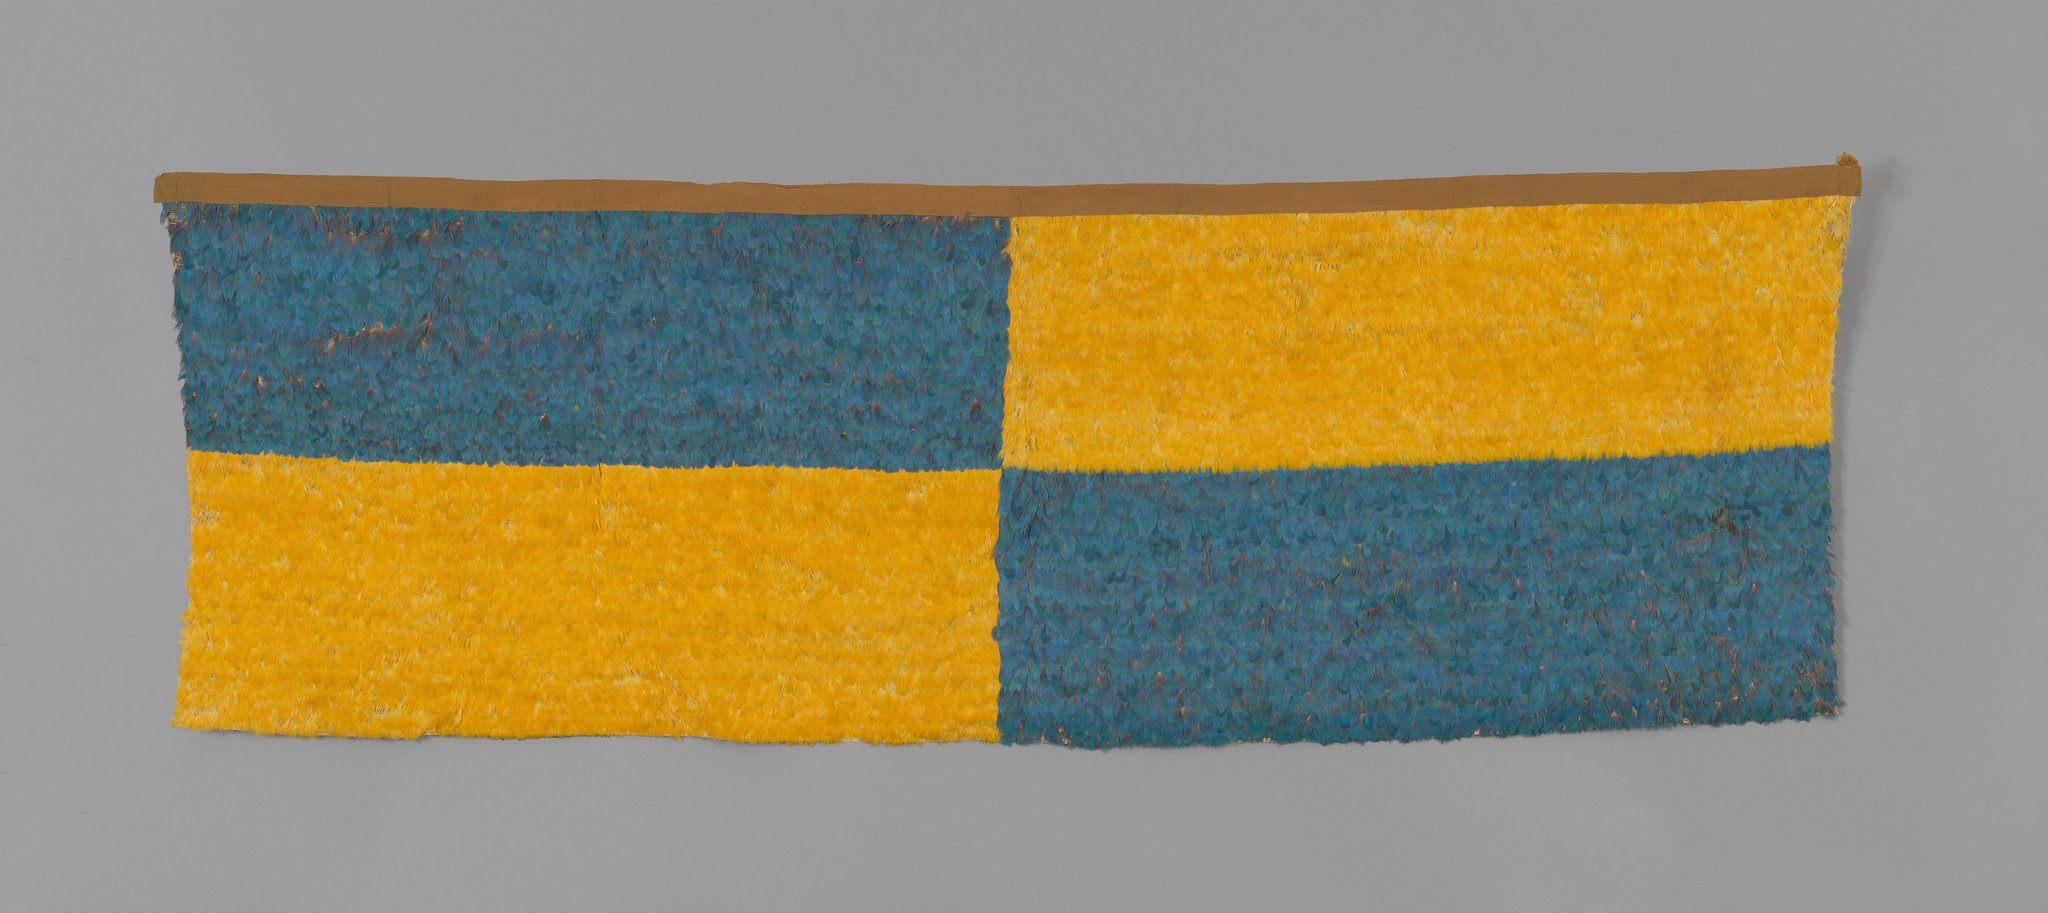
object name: panel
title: Feathered Panel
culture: wari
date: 600-900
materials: animal fiber, cotton, feather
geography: peru